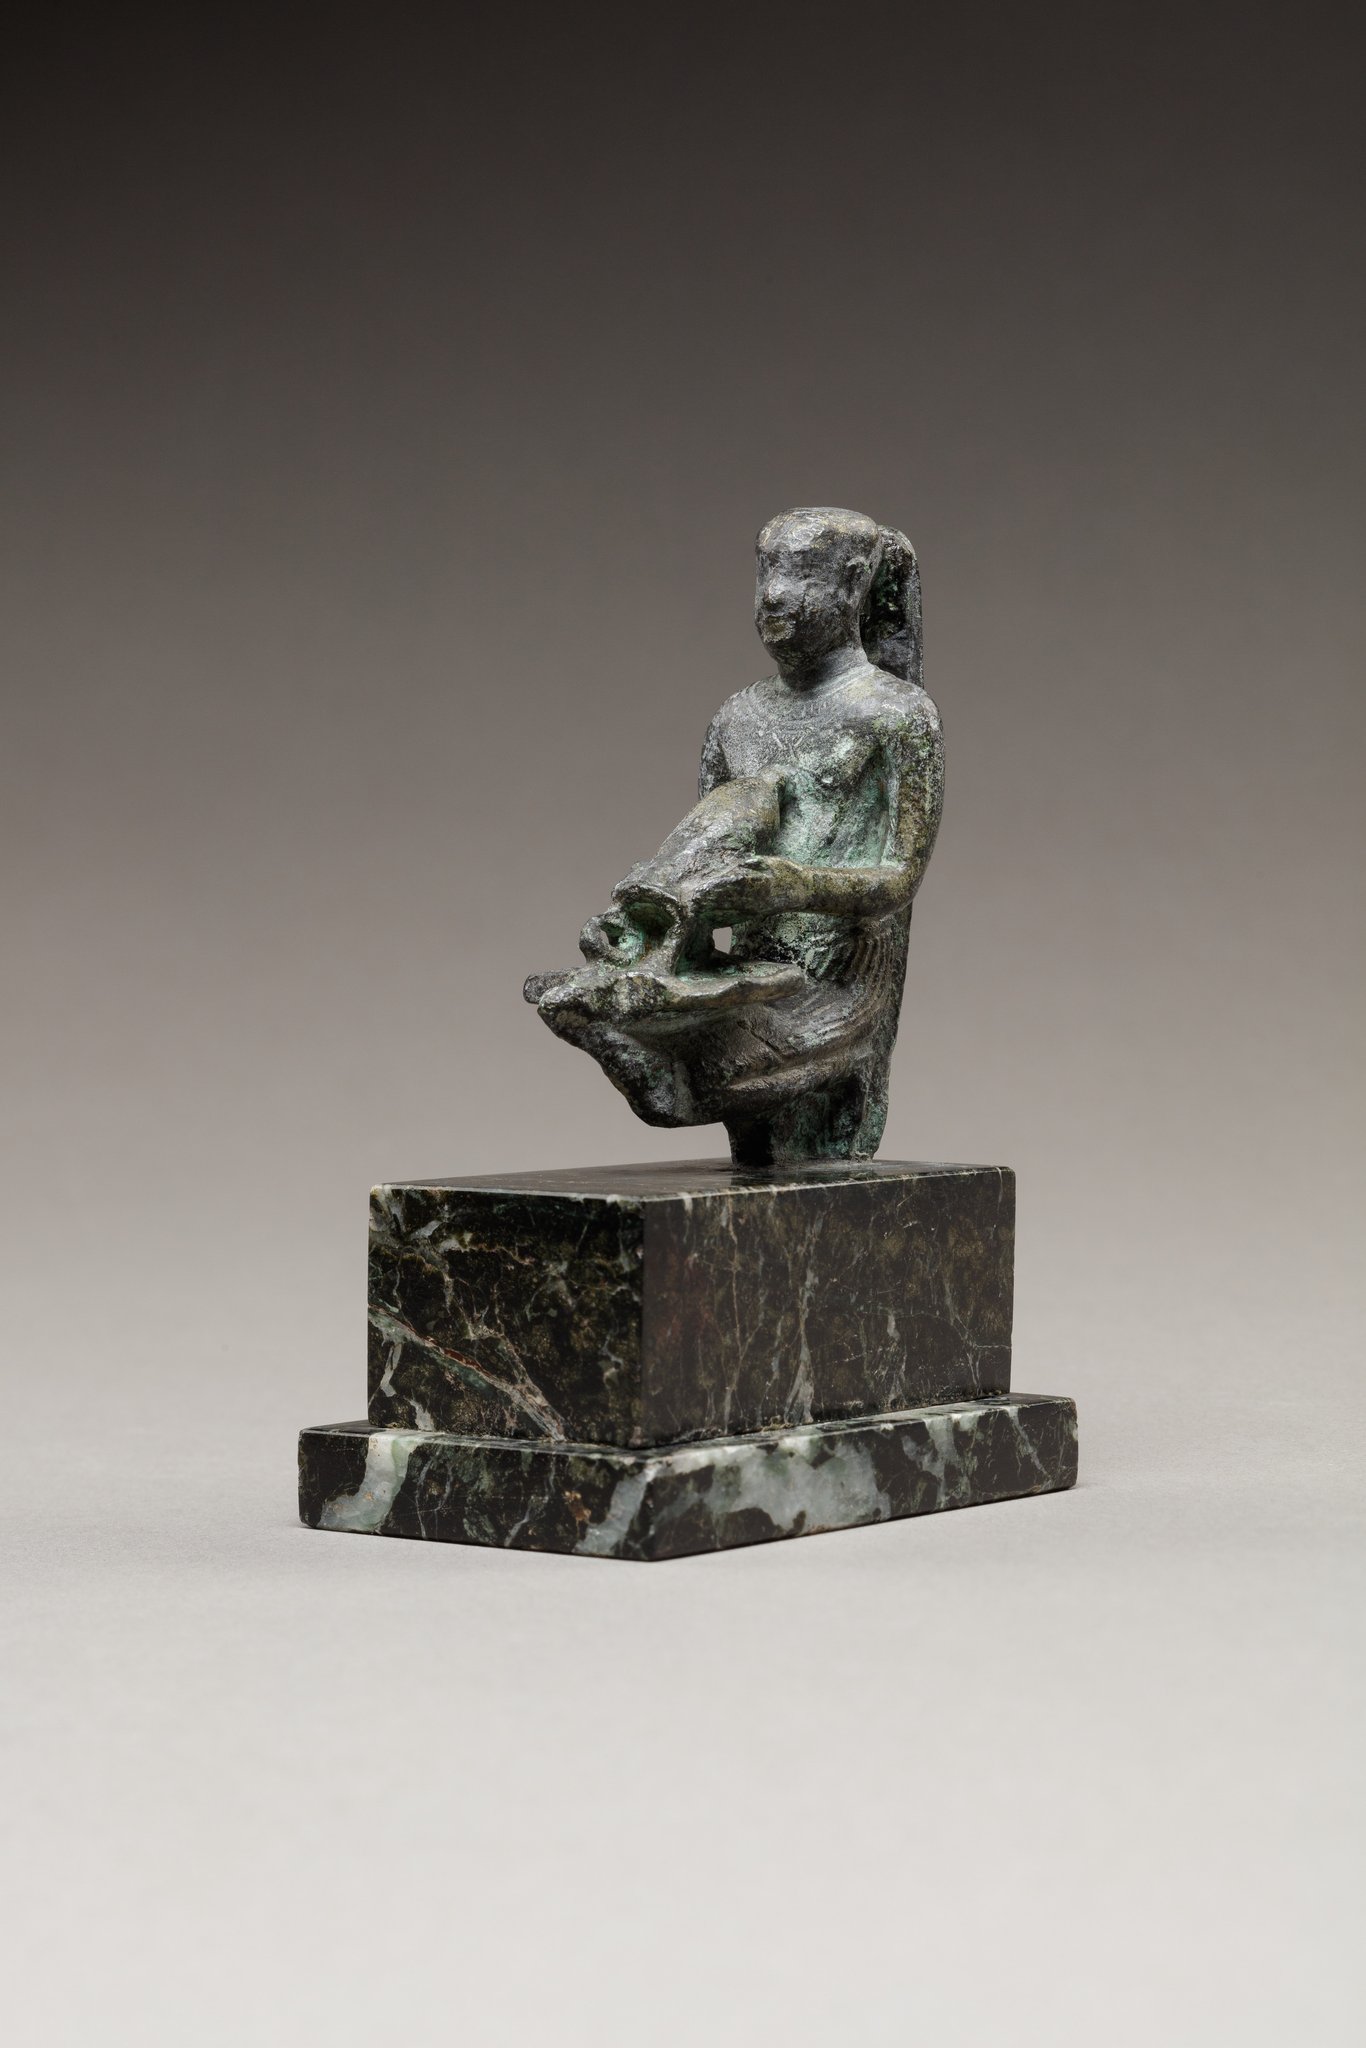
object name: priest, pediese, libation, kneeling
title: Pediese kneeling and pouring libation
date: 664-200 BCE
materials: copper alloy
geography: egypt